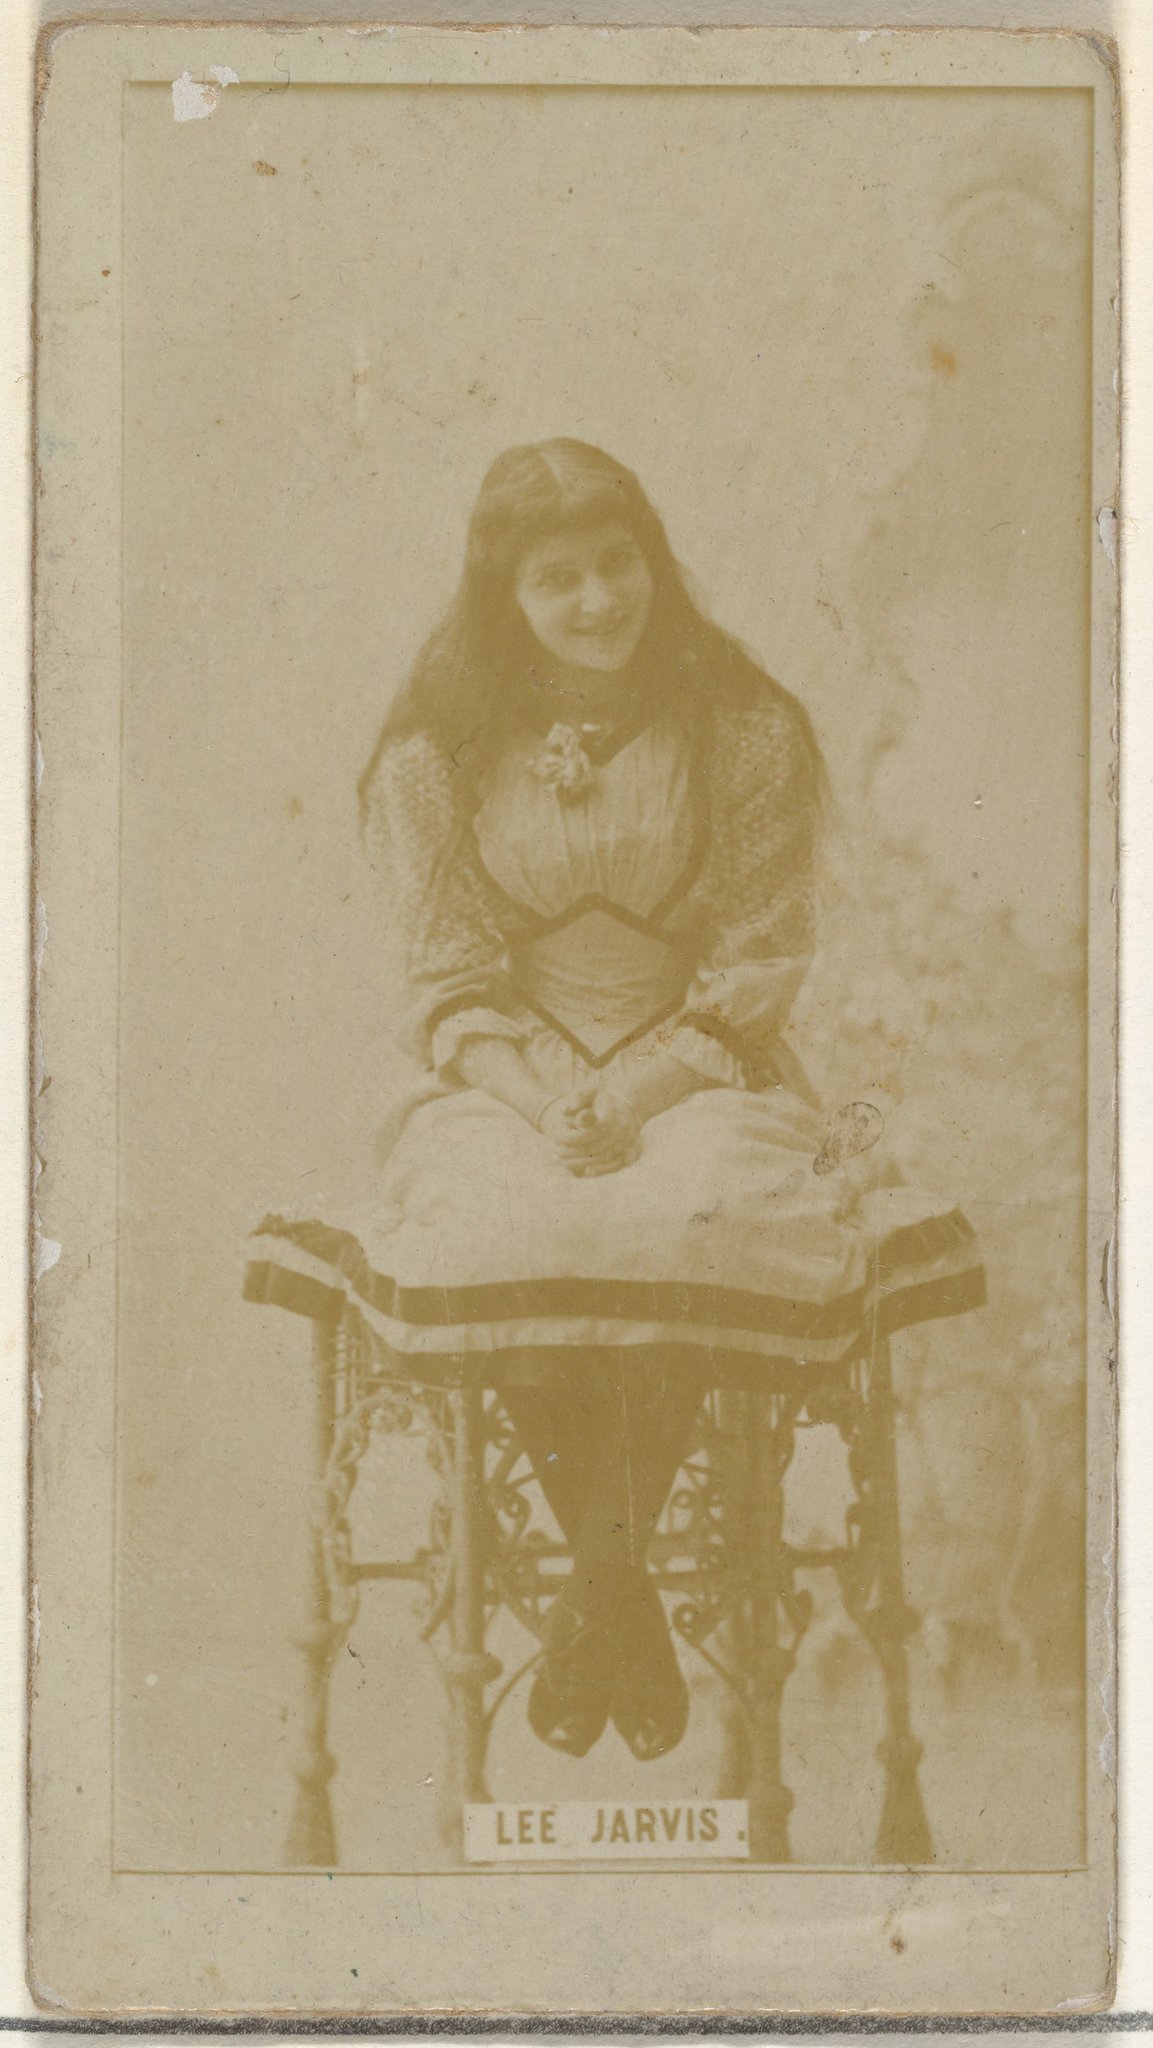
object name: photograph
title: Lee Jarvis, from the Actors and Actresses series (N145-8) issued by Duke Sons & Co. to promote Duke Cigarettes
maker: w. duke, sons & co.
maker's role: publisher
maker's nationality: american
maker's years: 1870-1920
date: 1891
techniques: albumen silver print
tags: portraits,women,actresses